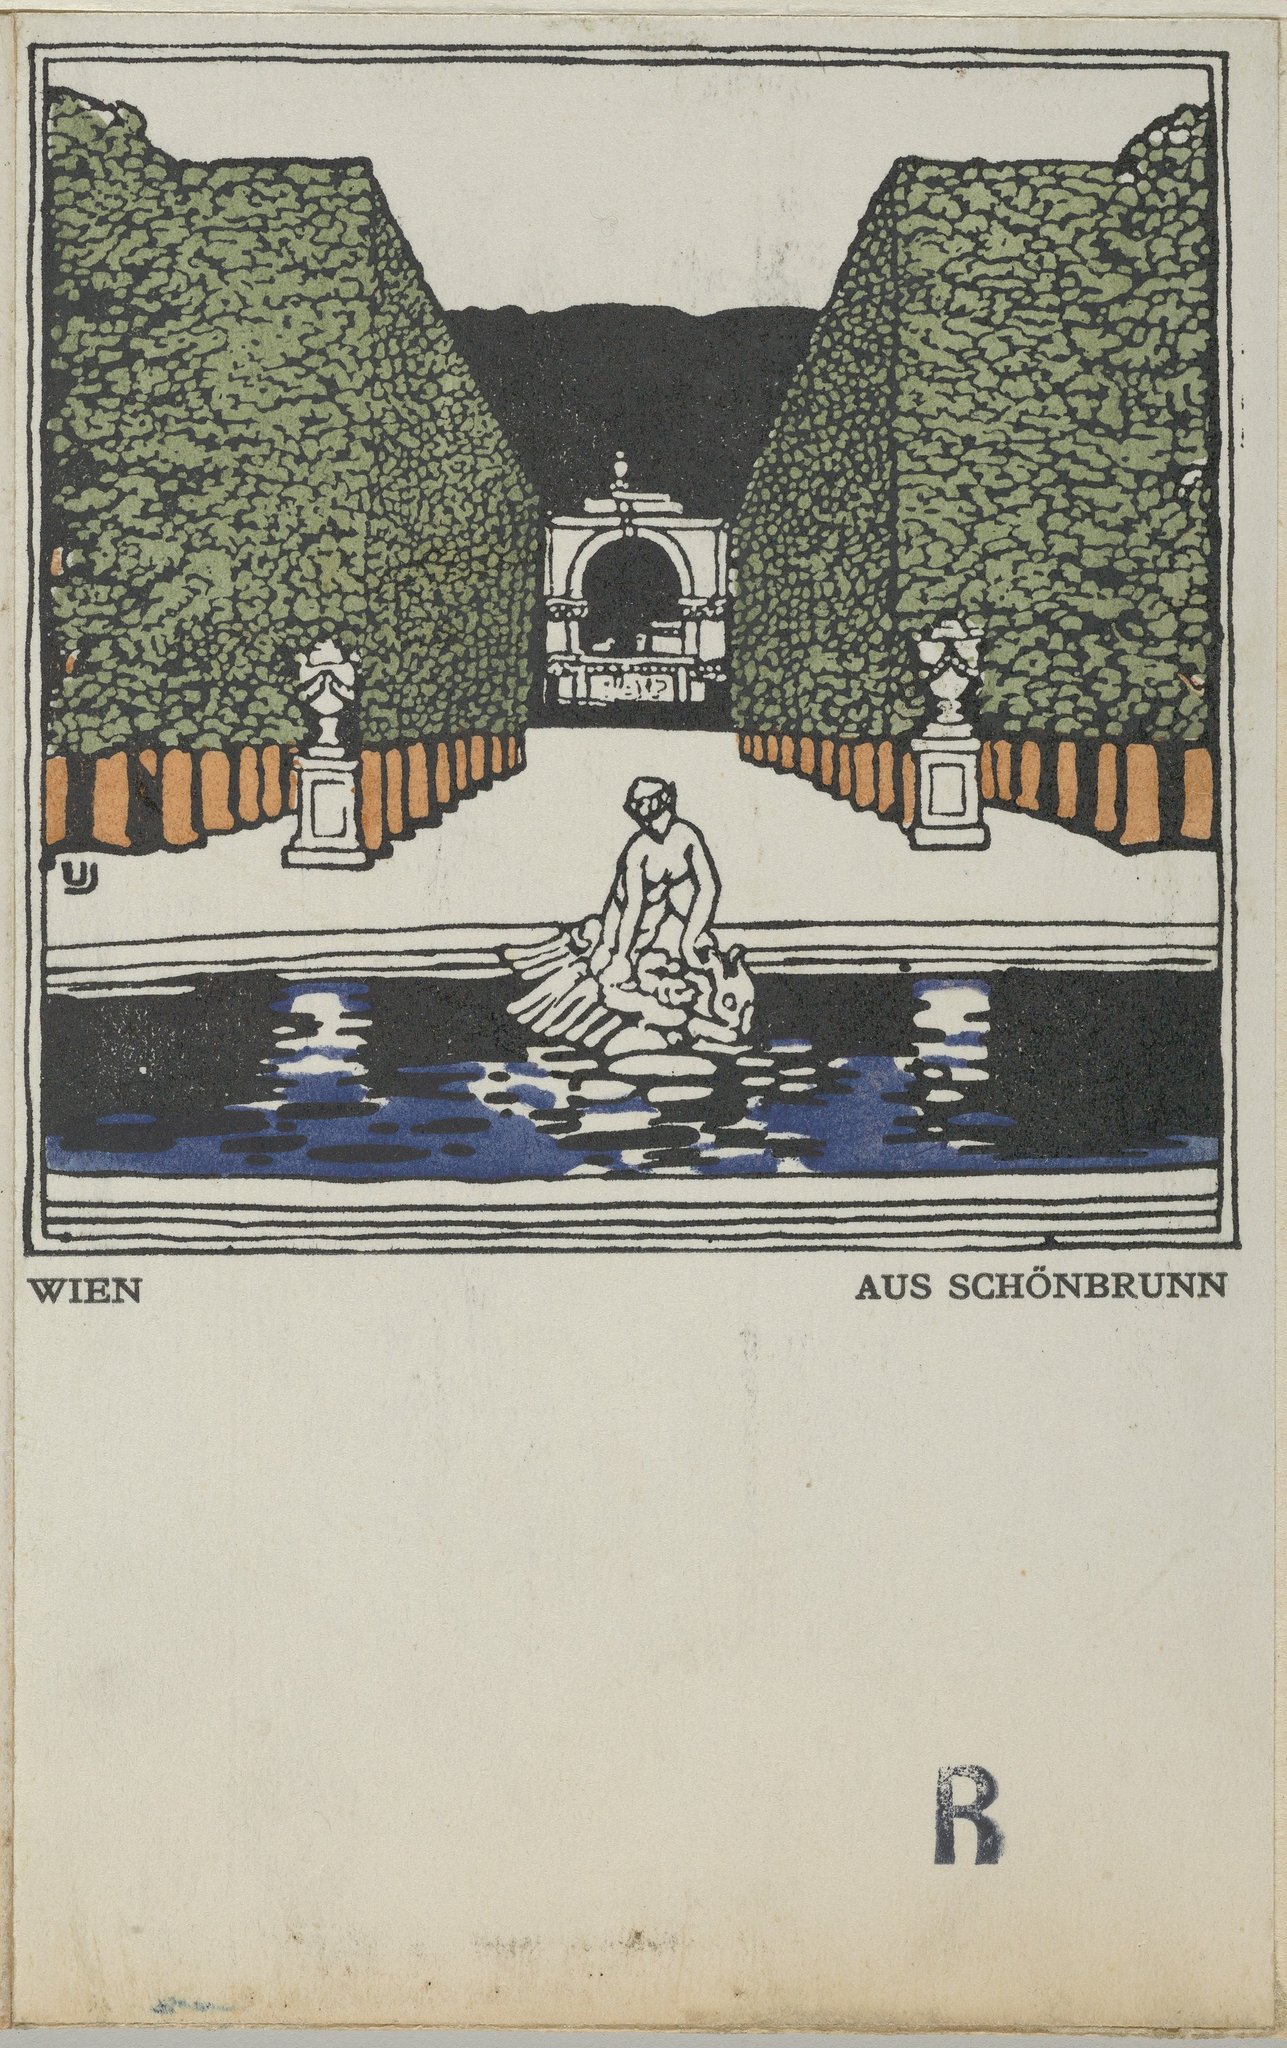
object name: print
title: Vienna: From Schönbrunn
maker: urban janke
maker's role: artist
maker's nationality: austrian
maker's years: 1887-1914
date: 1908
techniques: lithograph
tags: fountains,gardens